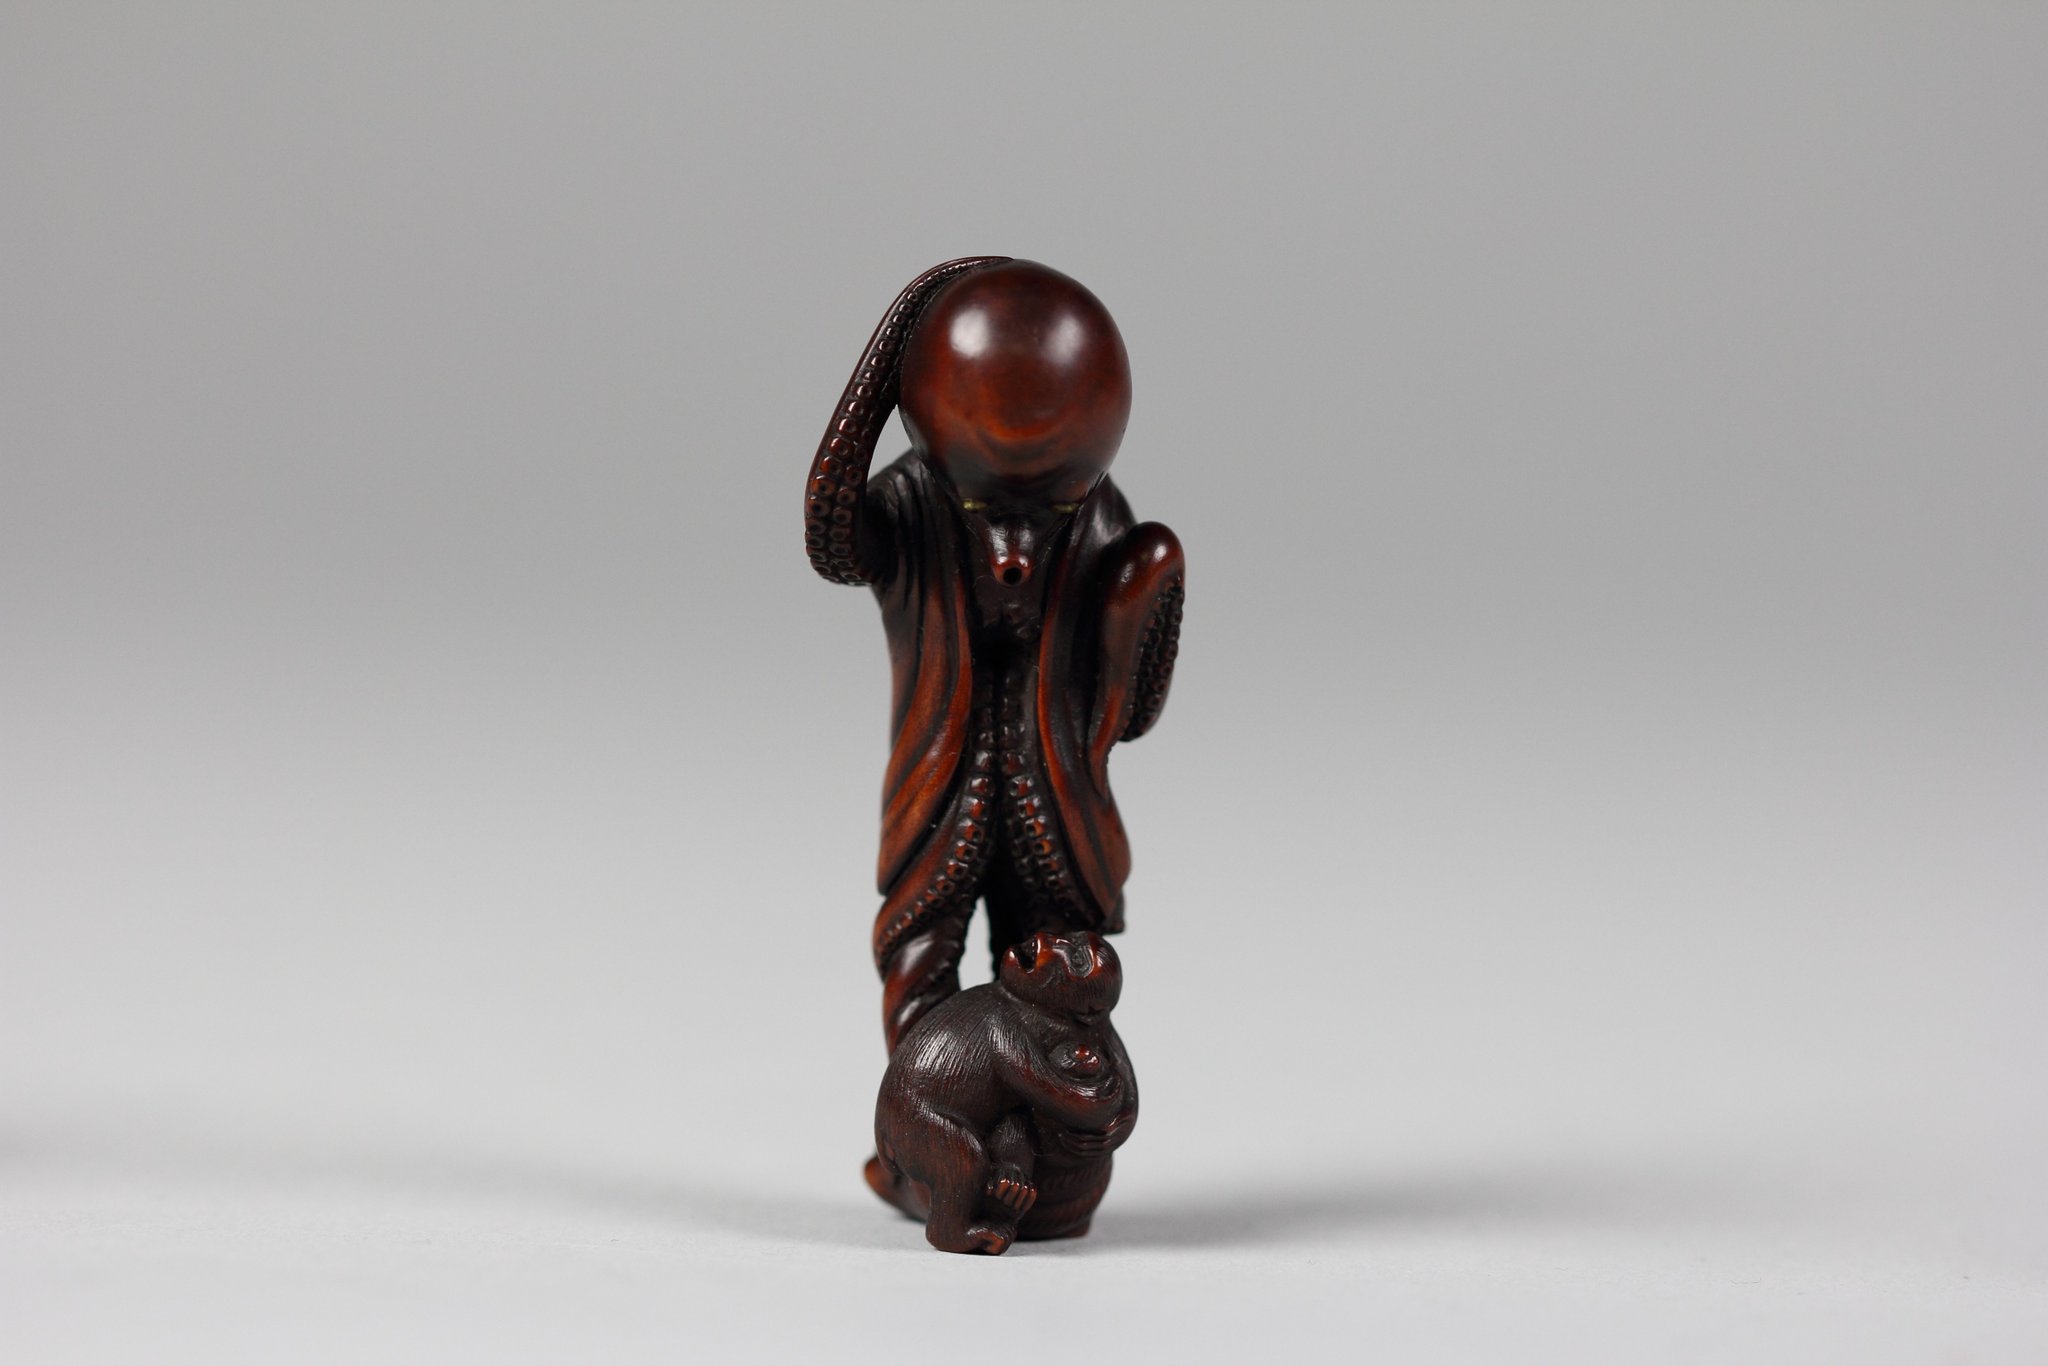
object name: netsuke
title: Netsuke of Octopus and Monkey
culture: japanese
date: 1801-1900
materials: wood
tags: monkeys,octopus